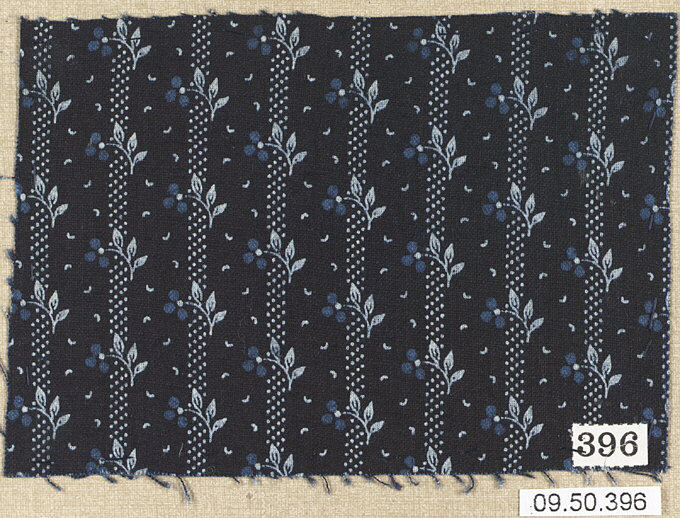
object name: piece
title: Piece (one of 116)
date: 1801-1900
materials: cotton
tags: flowers,leaves